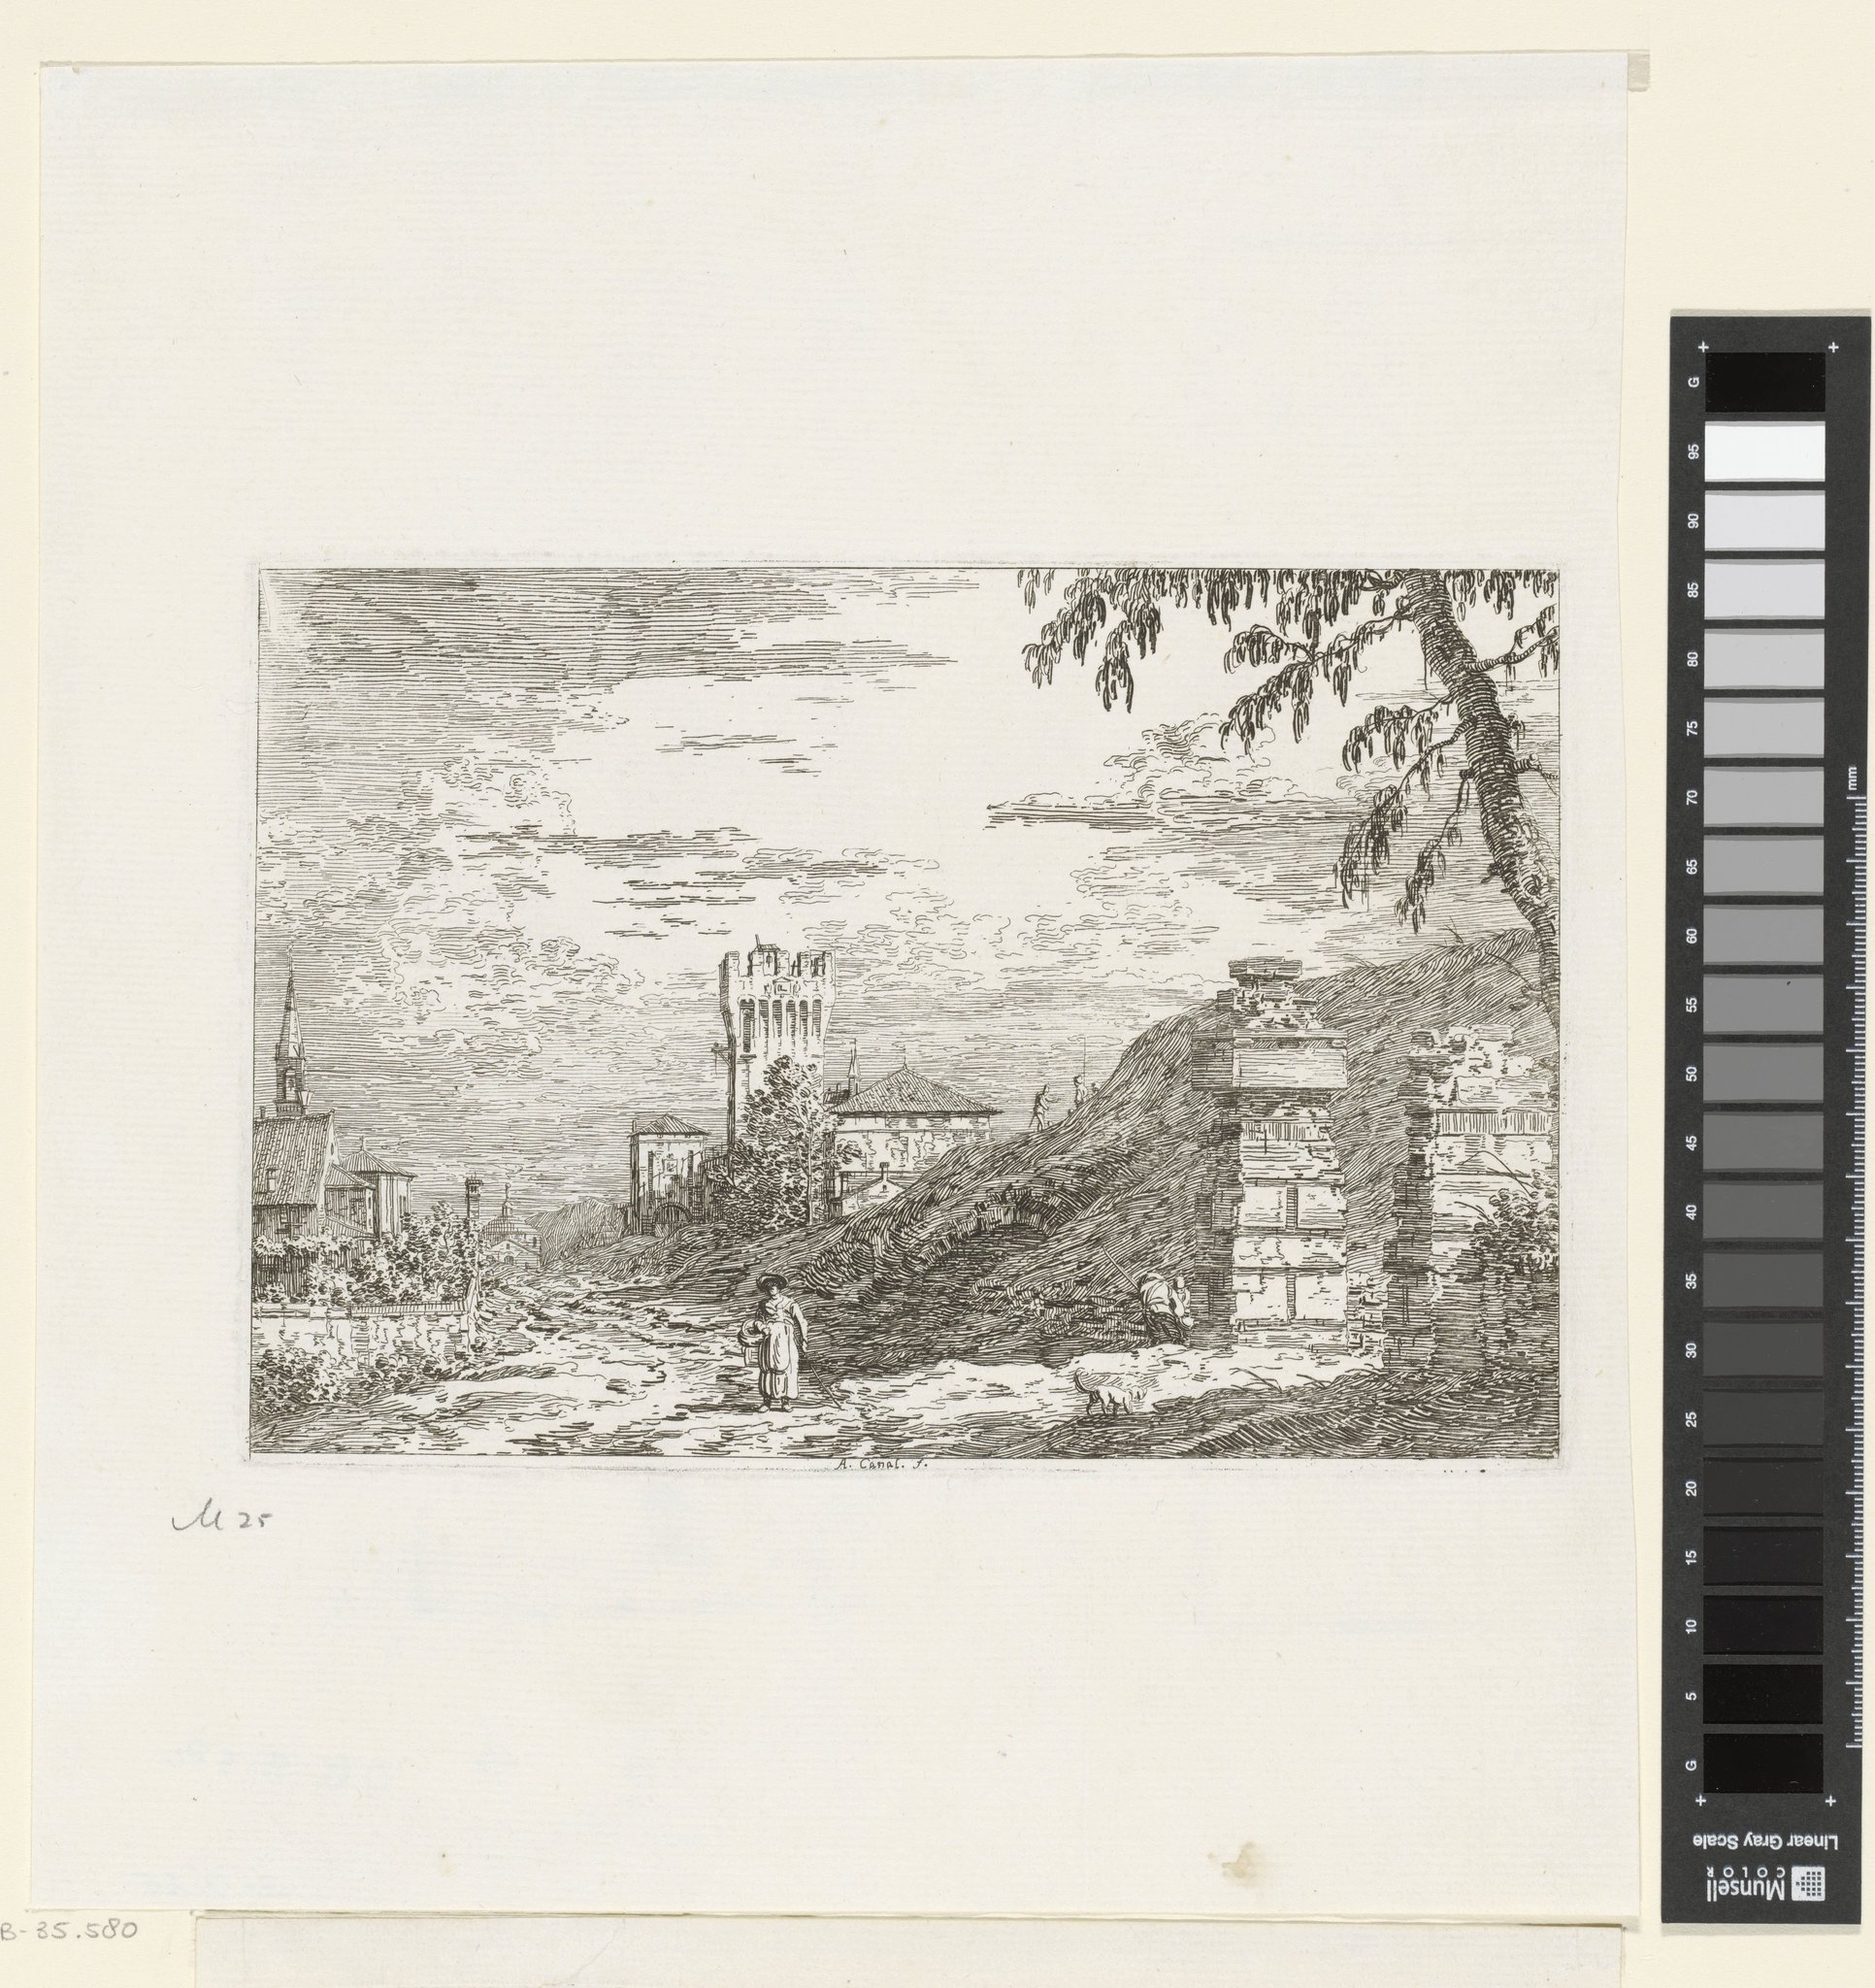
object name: print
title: Gezichten op bestaande en verzonnen plaatsen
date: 1707-1768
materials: paper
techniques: etching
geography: venice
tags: city-view, and landscape with man-made constructions, tower, clock tower ~ monumental adornment, landscape with ruins - ii - ideal landscapes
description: Een landschap met een toren. Op de voorgrond rechts twee resten van pijlers. Midden voor een vrouw.